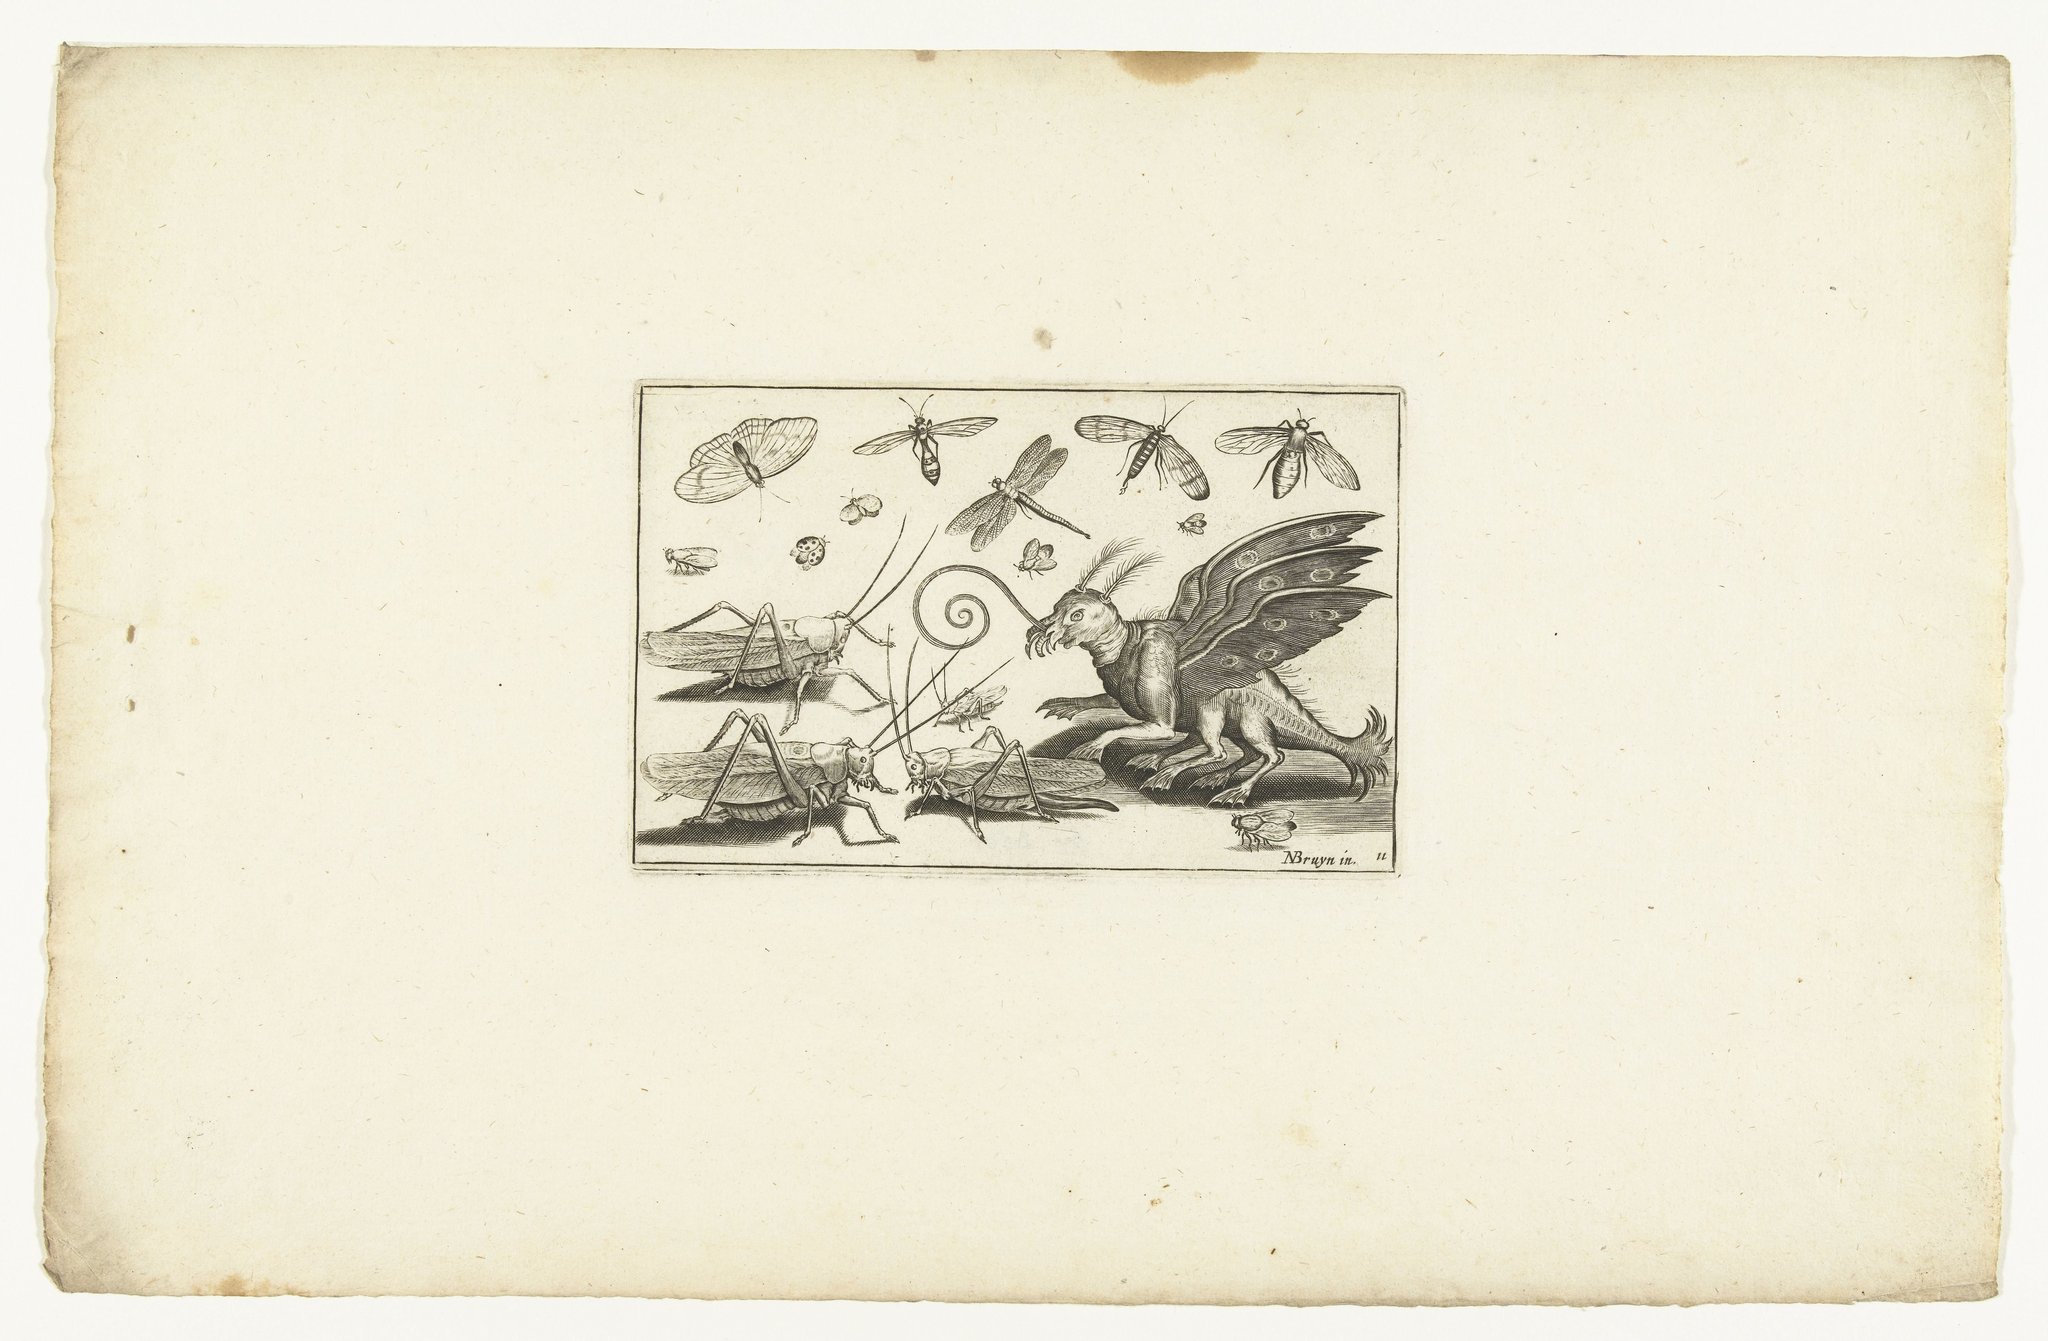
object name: ornament print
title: Volatilium varii generis (...)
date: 1581-1652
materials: paper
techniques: engraving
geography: amsterdam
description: Rechtsonder een fantasiebeest met vleugels, een vissenstaart en zes poten. Links verschillende sprinkhanen. Vlinder en insekten erboven. Tegenzijdige kopie van prent uit de serie beschreven bij Orn Cat I-37.10